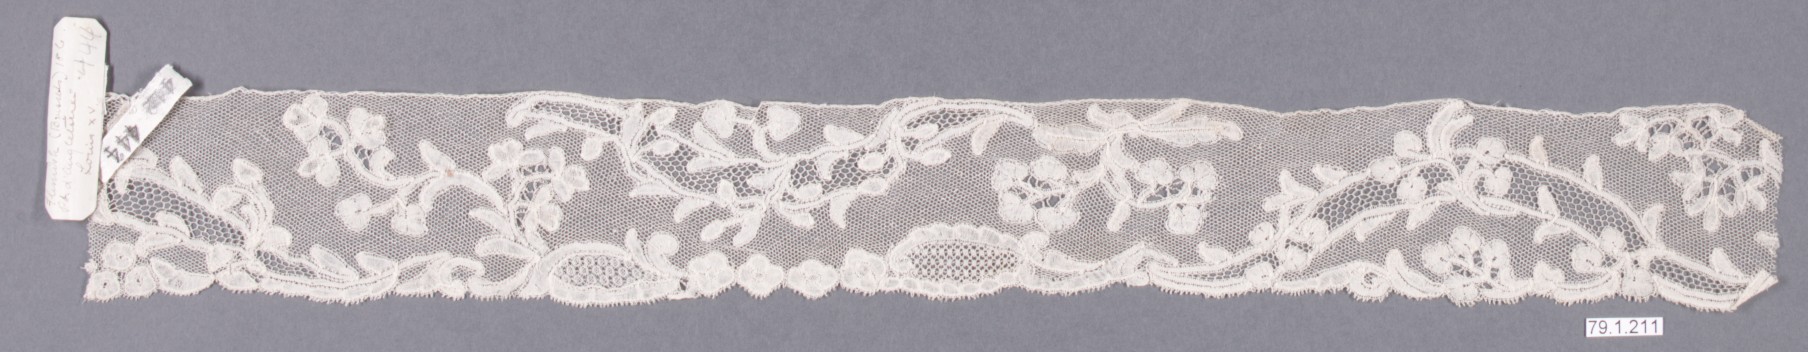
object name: strip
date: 1750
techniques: lace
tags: flowers